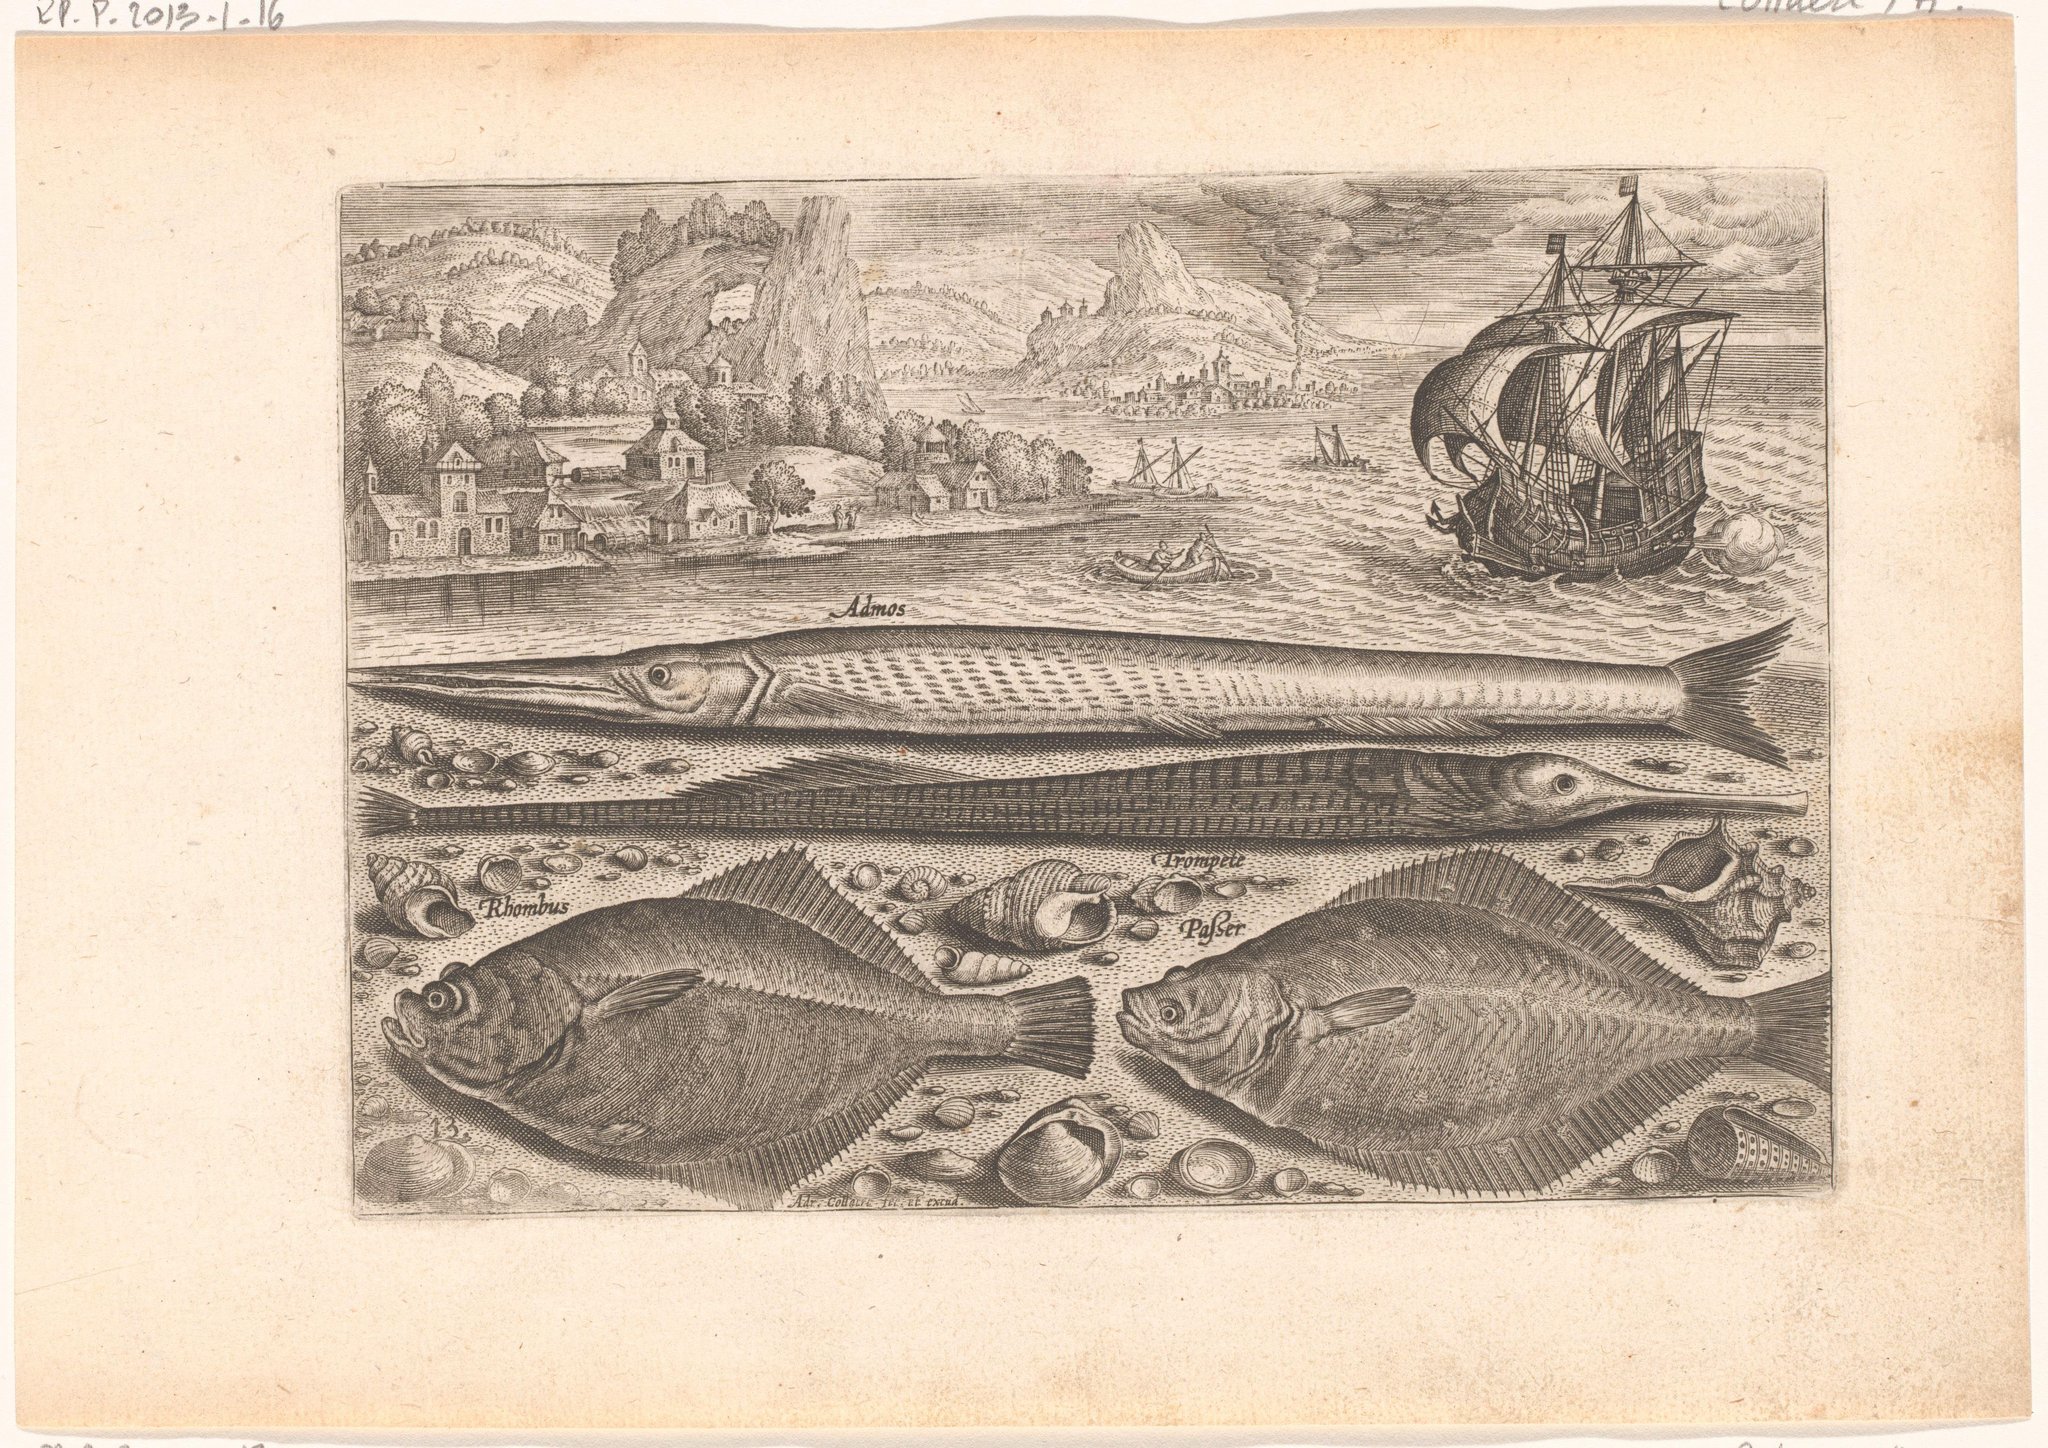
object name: print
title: Vier vissen op het strand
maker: adriaen collaert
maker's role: draughtsman, print maker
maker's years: 1560-1618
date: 1595-1618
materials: paper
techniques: engraving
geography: antwerp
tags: sea (seascape), bony fishes: pipefish, bony fishes: plaice, bony fishes: brill, bony fishes: garfish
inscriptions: number: ‘54/17’, collector's mark: Lugt 2228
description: Een geep, een zeenaald, een griet en een schol liggen aangespeld op het strand samen met wat schelpen. Op de achtergrond de zee met enkele schepen. De prent maakt deel uit van een serie met vissen als onderwerp.